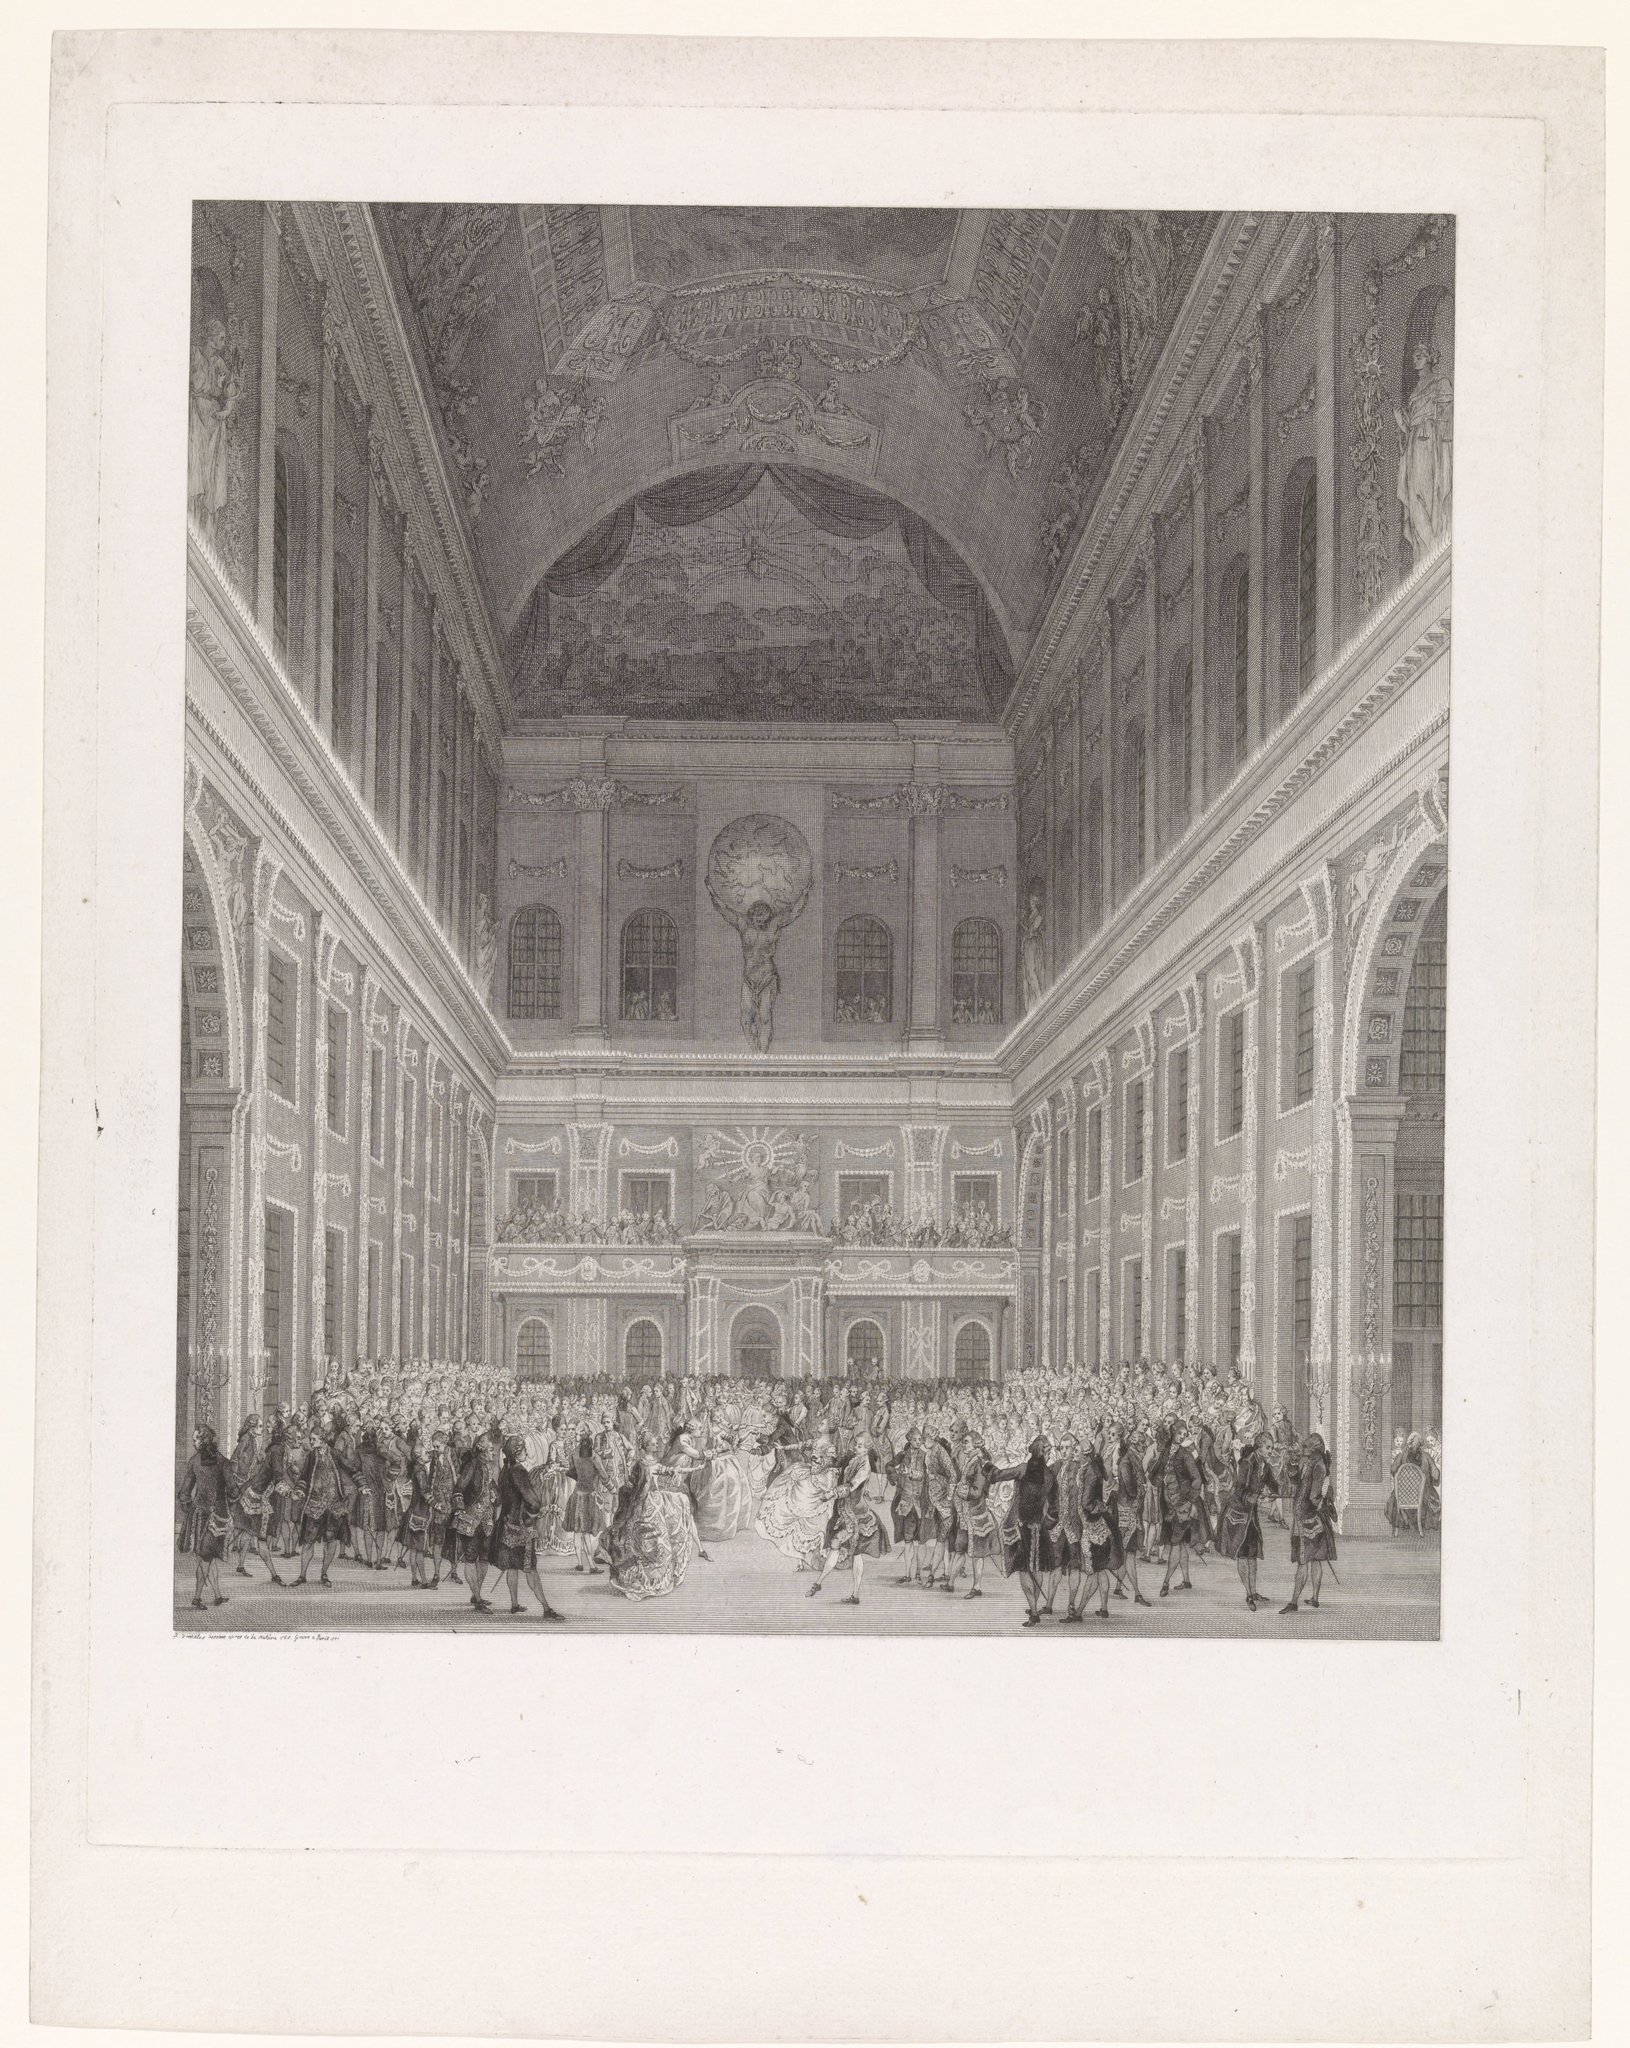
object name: print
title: Afbeelding der Vreugdebedryven en Plegtigheden die by de aankomst en gedurende het verblyf (...) Willem (...) en zyne Gemaalinne (...) zyn voorgevallen te Amsterdam, op maandag, den 30 Mey, en eenige volgende dagen, des jaars 1768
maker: reinier vinkeles (i)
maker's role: draughtsman, print maker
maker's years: 1741-1816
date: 1771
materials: paper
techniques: engraving, etching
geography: paris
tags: the hague, william v (prince of orange), painter, draughtsman, wilhelmina of prussia (princess of orange), public festivities on the occasion of royal events (+ dancing ~ festive activities), ball, formal dance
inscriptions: collector's mark: Lugt 2228, signature and date: ‘R: Vinkeles dessine apres de la Nature 1768. Grave a Paris 1771’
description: Het bal in de Burgerzaal van het Amsterdamse stadhuis gegeven door het stadsbestuur ter gelegenheid van het bezoek van stadhouder Willem V en prinses Wilhelmina van Pruisen, 2 juni 1768. Onderdeel van een prentserie met titelprent en 14 platen van de inhaling van de prins en prinses te Amsterdam, 30 mei - 4 juni 1768.